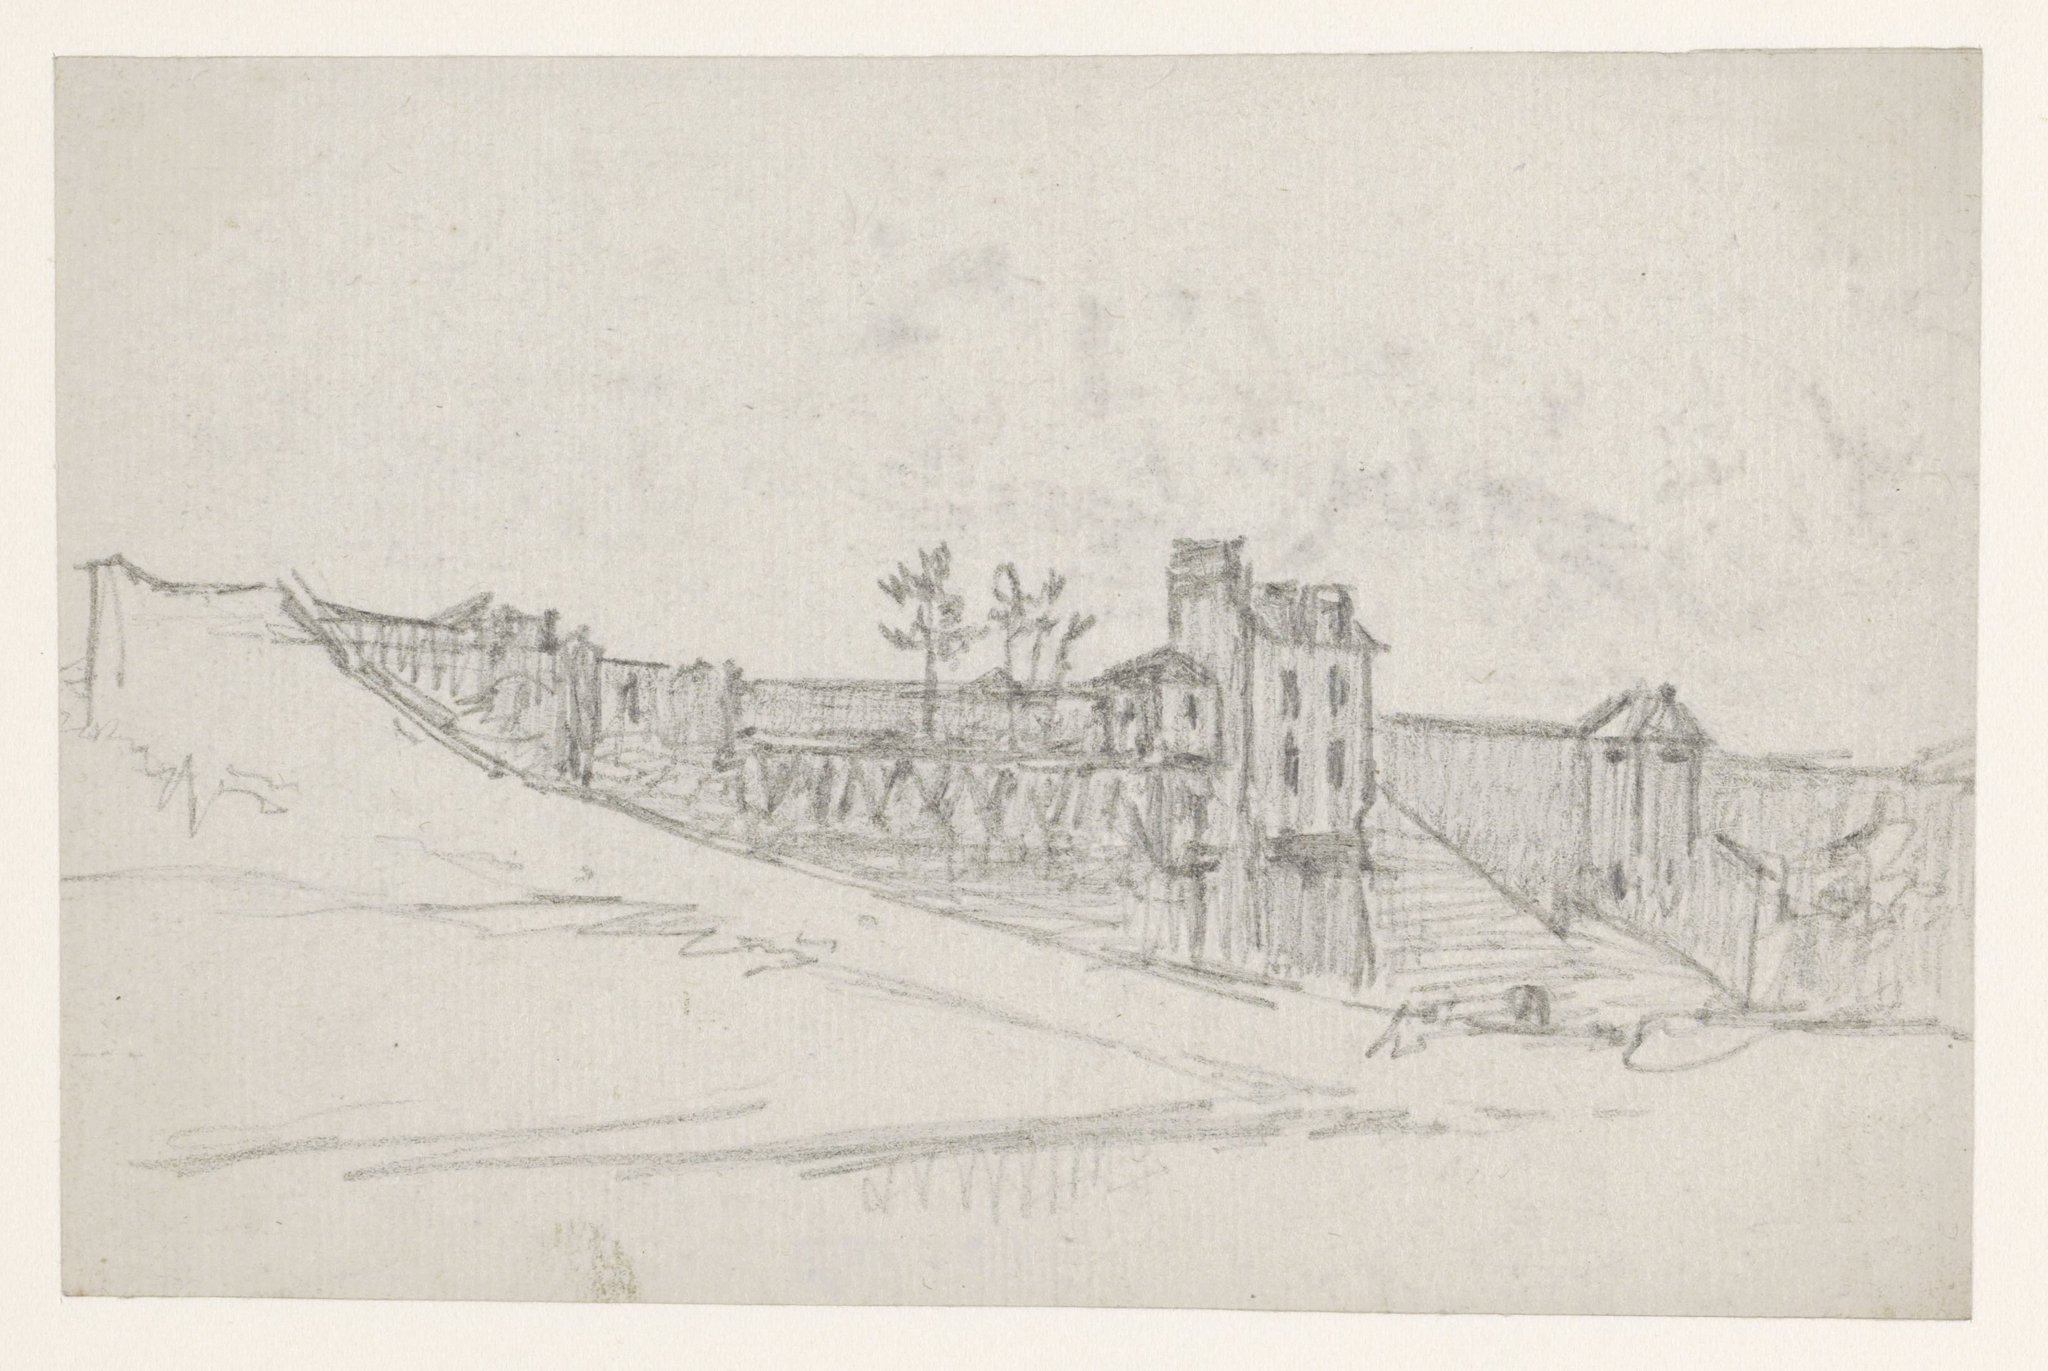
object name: drawing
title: Trappen op Montmartre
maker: georges michel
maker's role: draughtsman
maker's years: 1763-1843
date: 1773-1843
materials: paper, pencil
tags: sloping street; street with steps or stairs, public road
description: Een van 120 tekeningen, afkomstig uit een 19e eeuws album met tekeningen van Georges Michel.